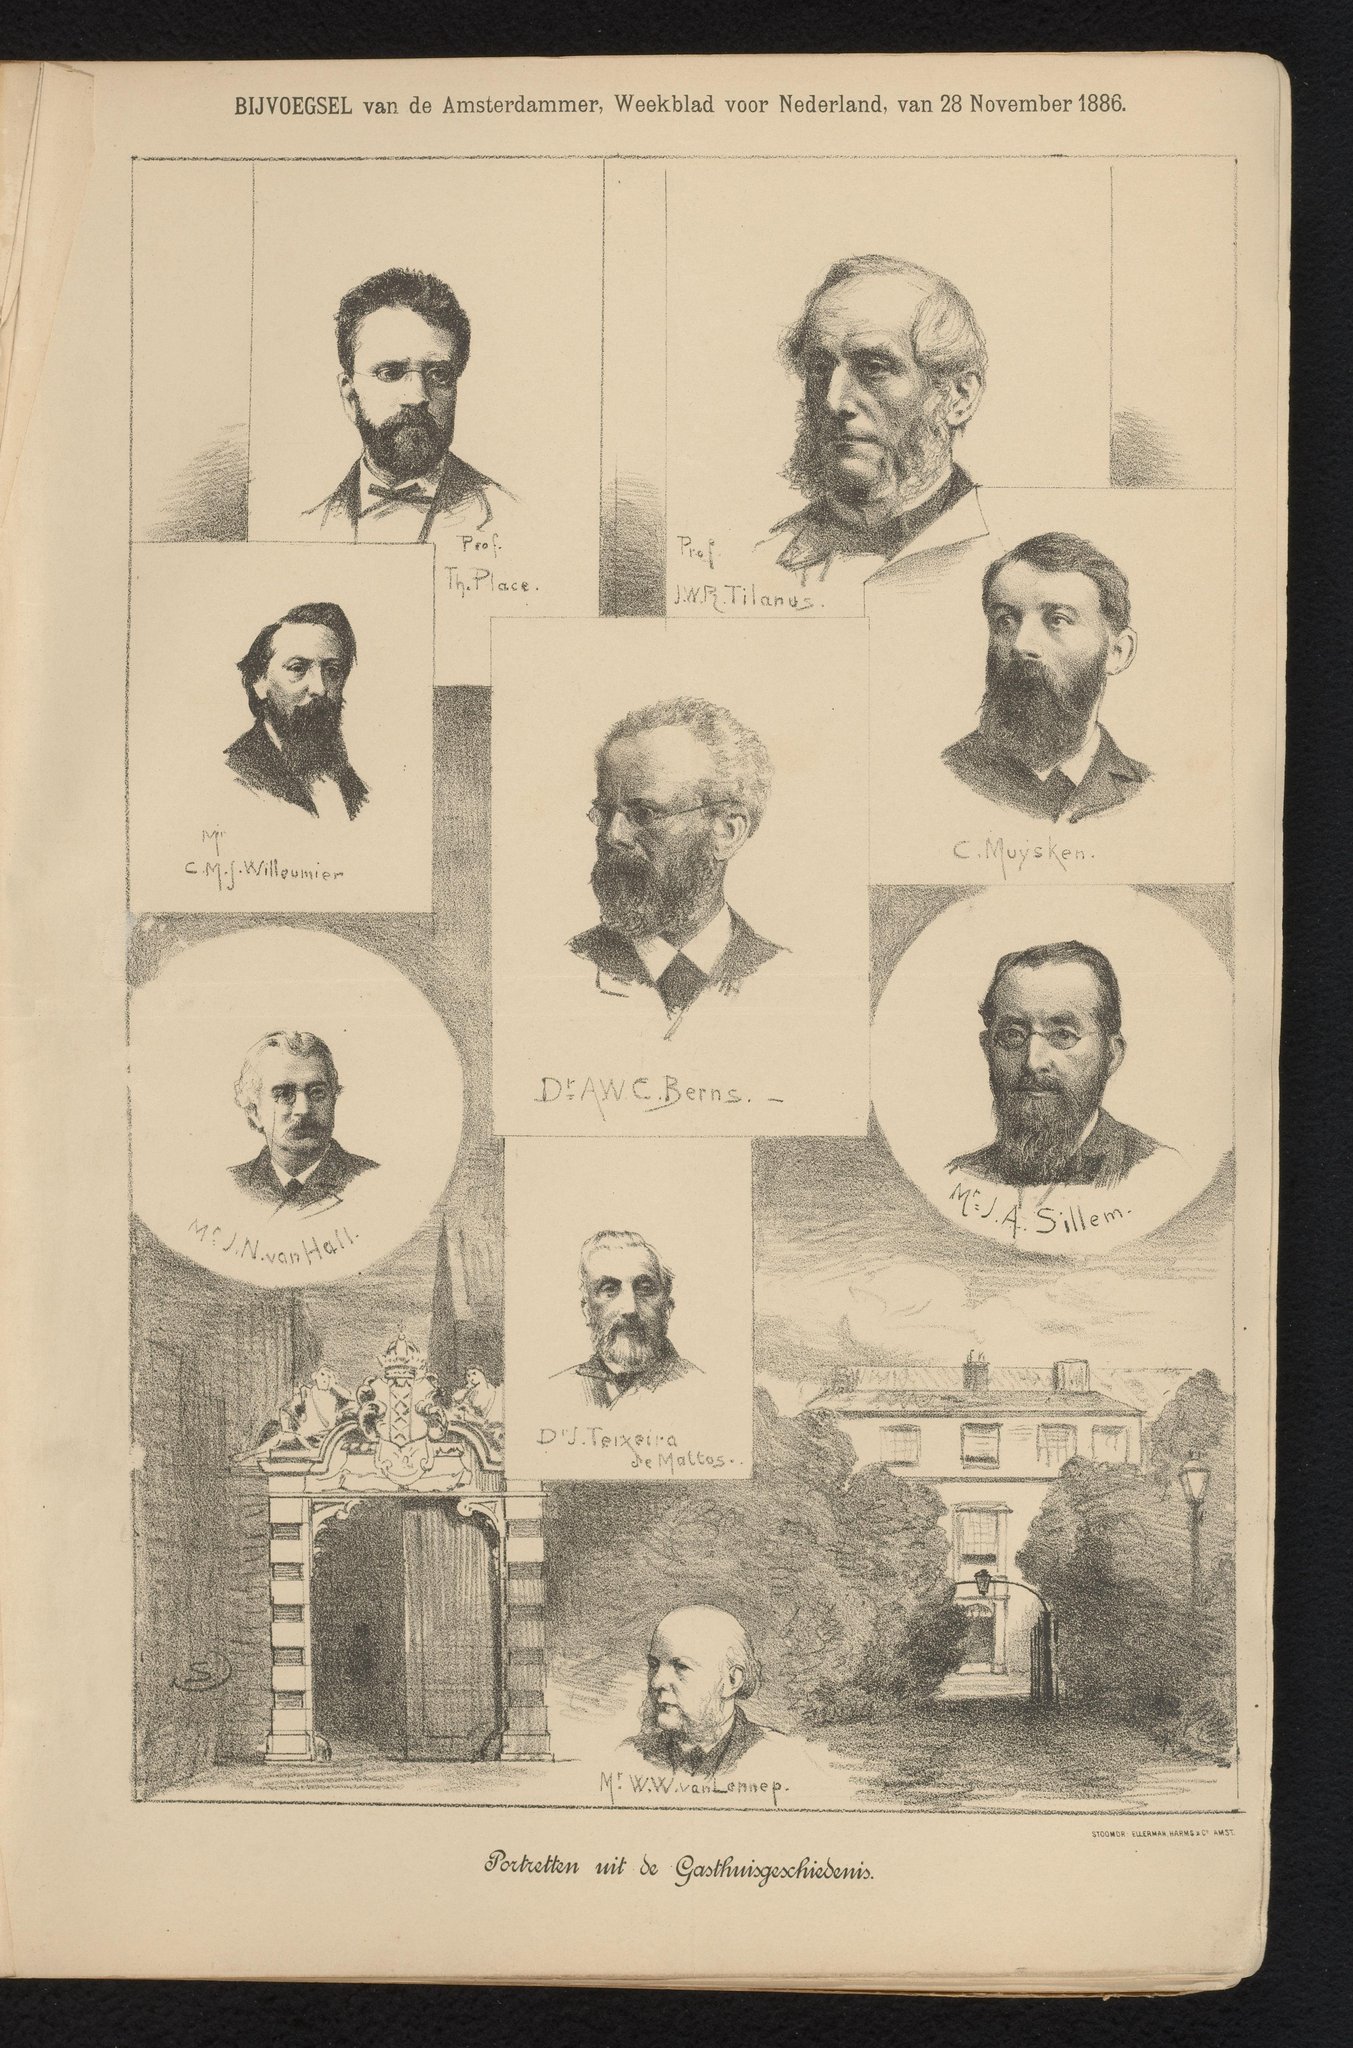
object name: print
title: Portretten uit de Gasthuisgeschiedenis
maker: willem steelink (ii)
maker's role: draughtsman, print maker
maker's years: 1856-1928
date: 1886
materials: paper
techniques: lithograph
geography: amsterdam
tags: historical persons, hospital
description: Het Amsterdamse Binnengasthuis en het nieuwe Buitengasthuis, met portretten van mannen verbonden aan de geschiedenis van de instellingen.